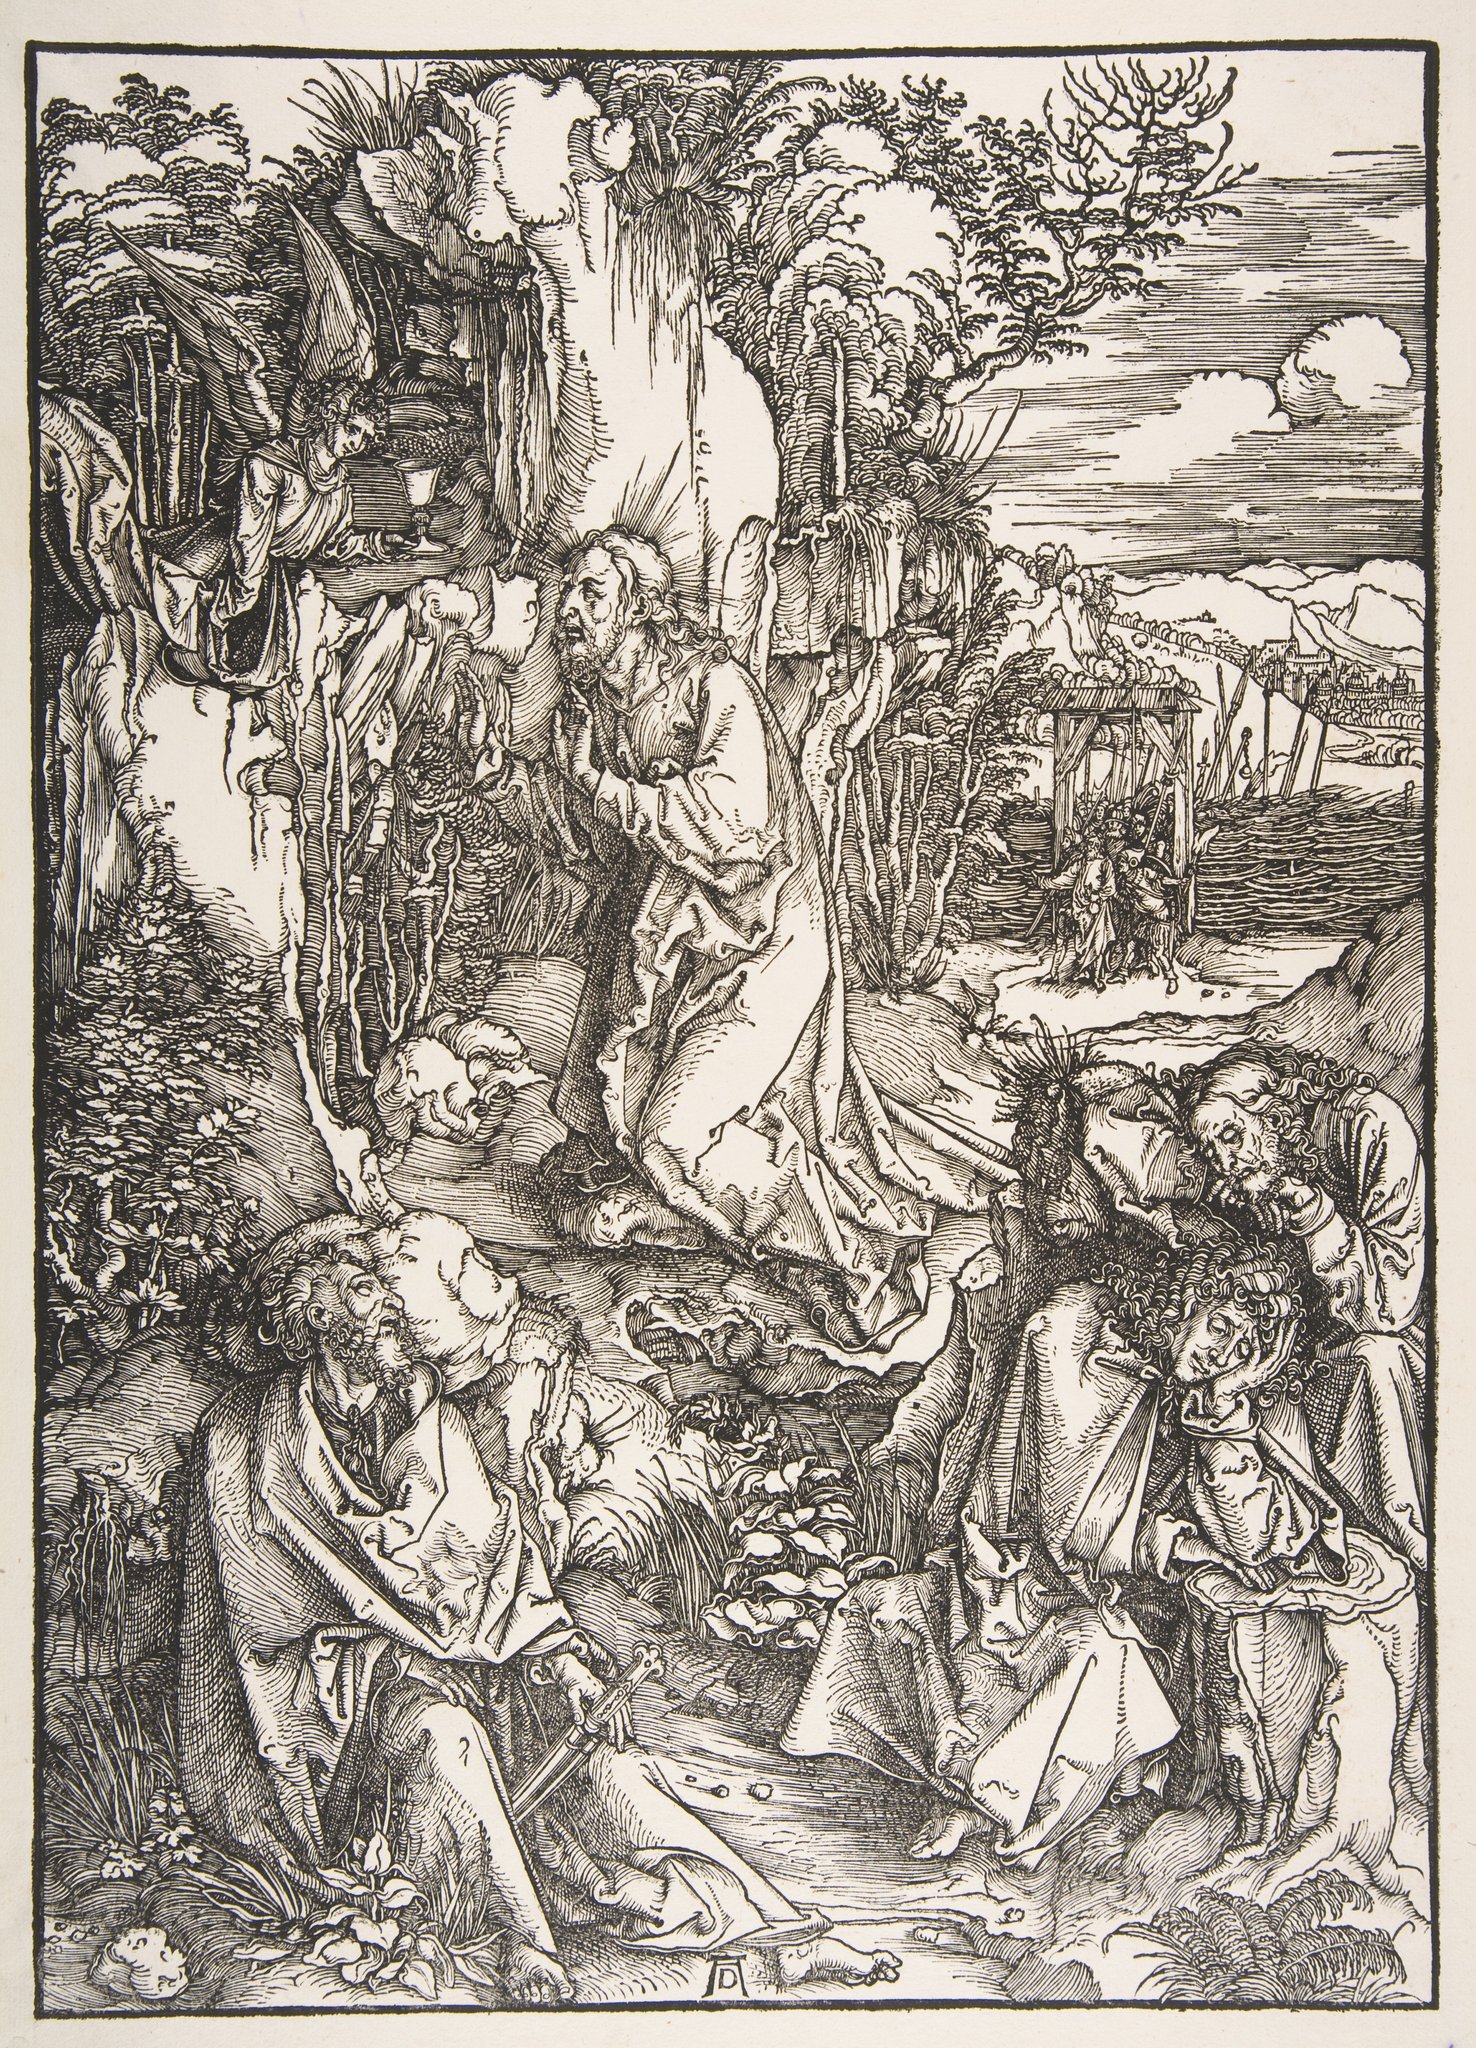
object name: print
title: Christ on the Mount of Olives, from The Large Passion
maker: albrecht dürer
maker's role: artist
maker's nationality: german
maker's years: 1471-1528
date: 1497-1499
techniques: woodcut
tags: men,olive trees,christ